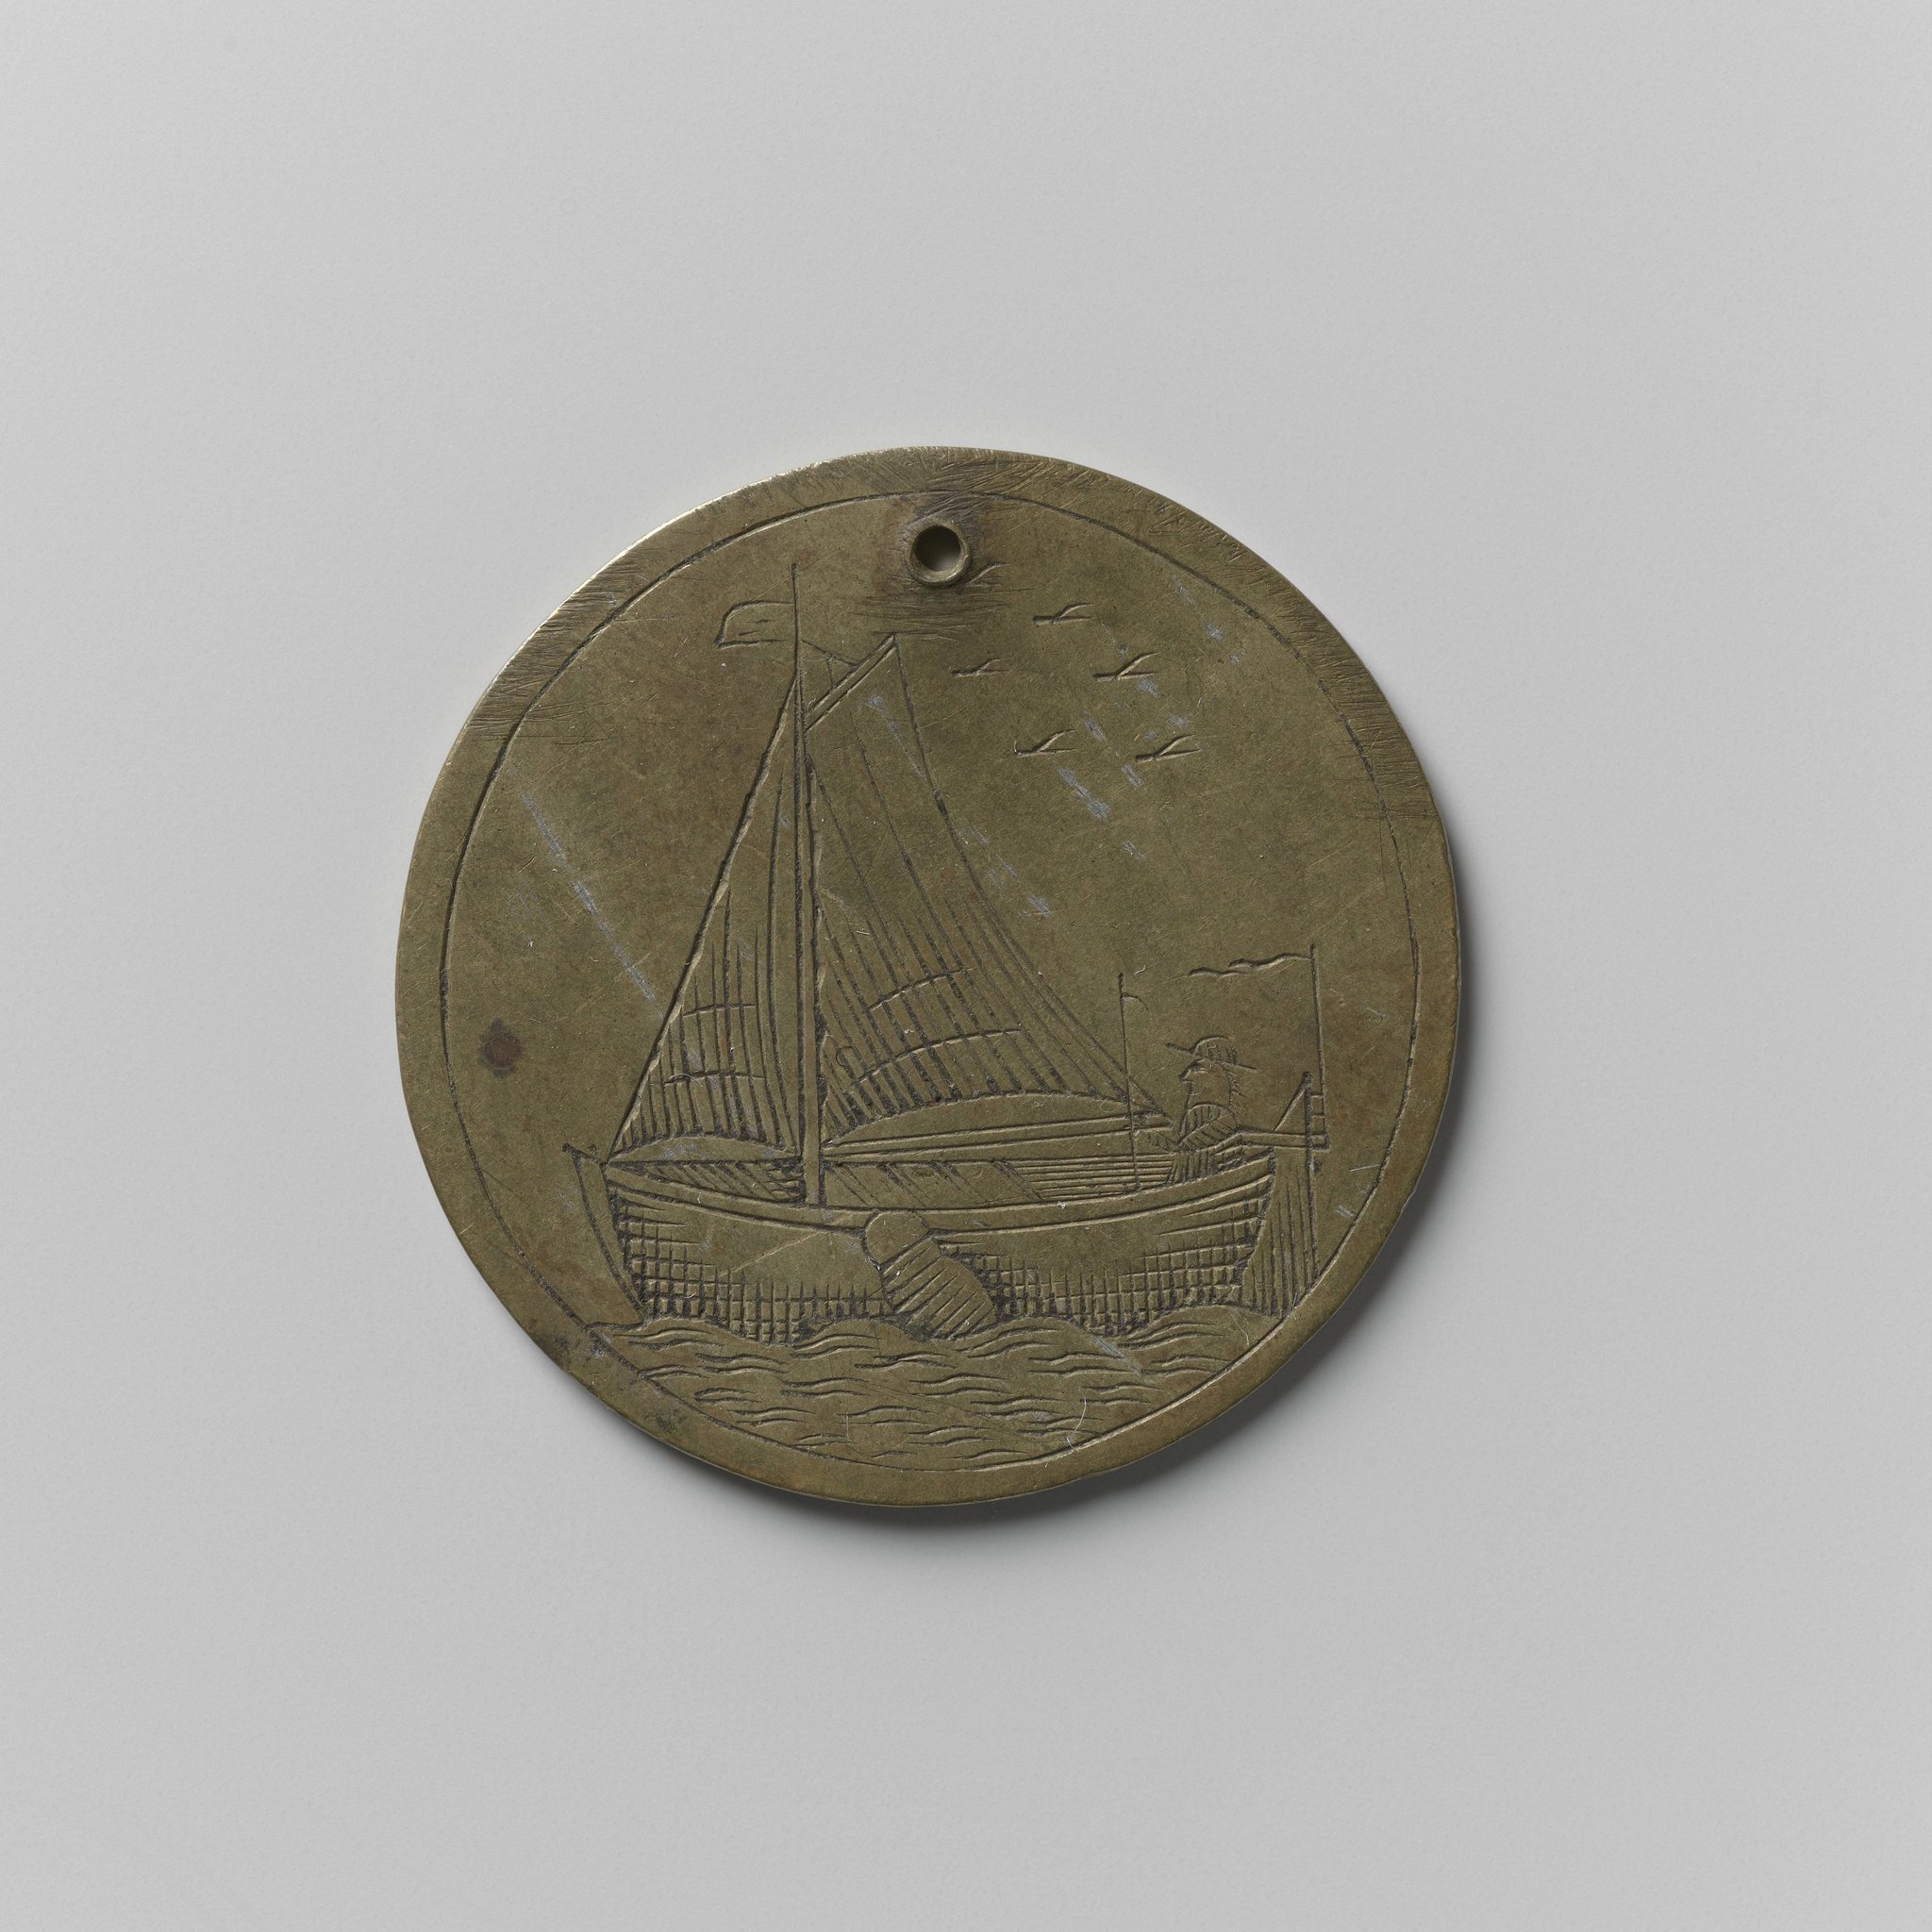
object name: medal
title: Roei-, steiger- en schuitenvoerdersgilde van Amsterdam, gildepenning van Dierk Hartgers, ligplaats Nieuwe Brug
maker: Anonymous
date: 1745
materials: brass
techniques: engraving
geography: amsterdam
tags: amsterdam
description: Messing penning met gat erin. Voorzijde: naar links varende zeilboot; op achterplecht: zittende man en vlag. Keerzijde: opschrift boven huismerk en hart met daarin letters D en H tussen monogram van letters N en B